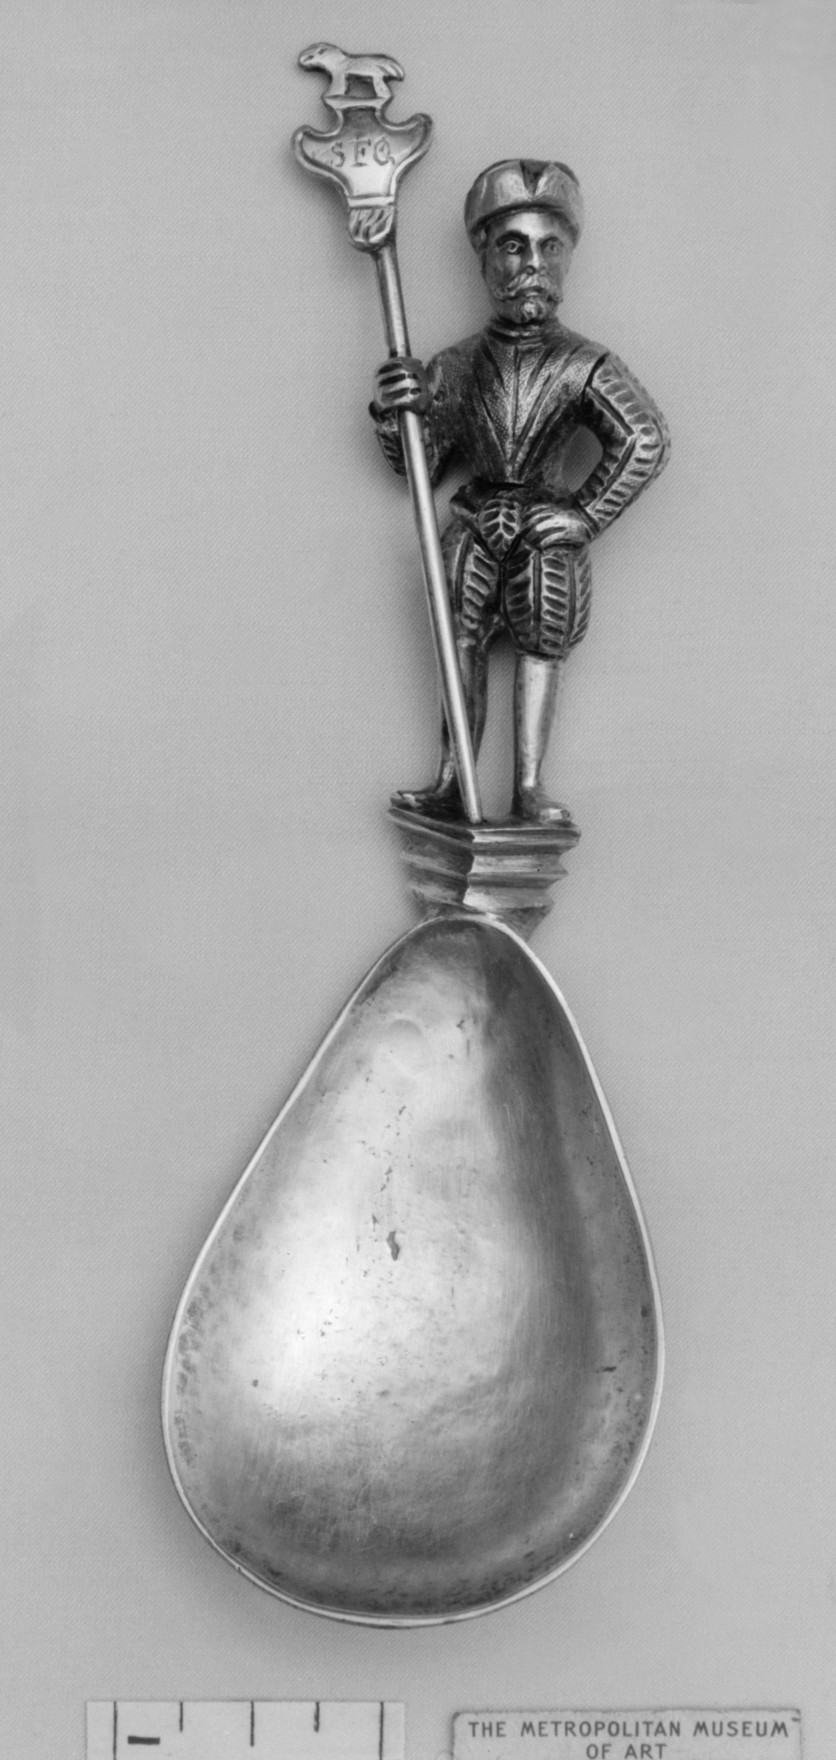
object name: spoon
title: Figure-top spoon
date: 1551-1600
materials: gilt, silver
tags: men